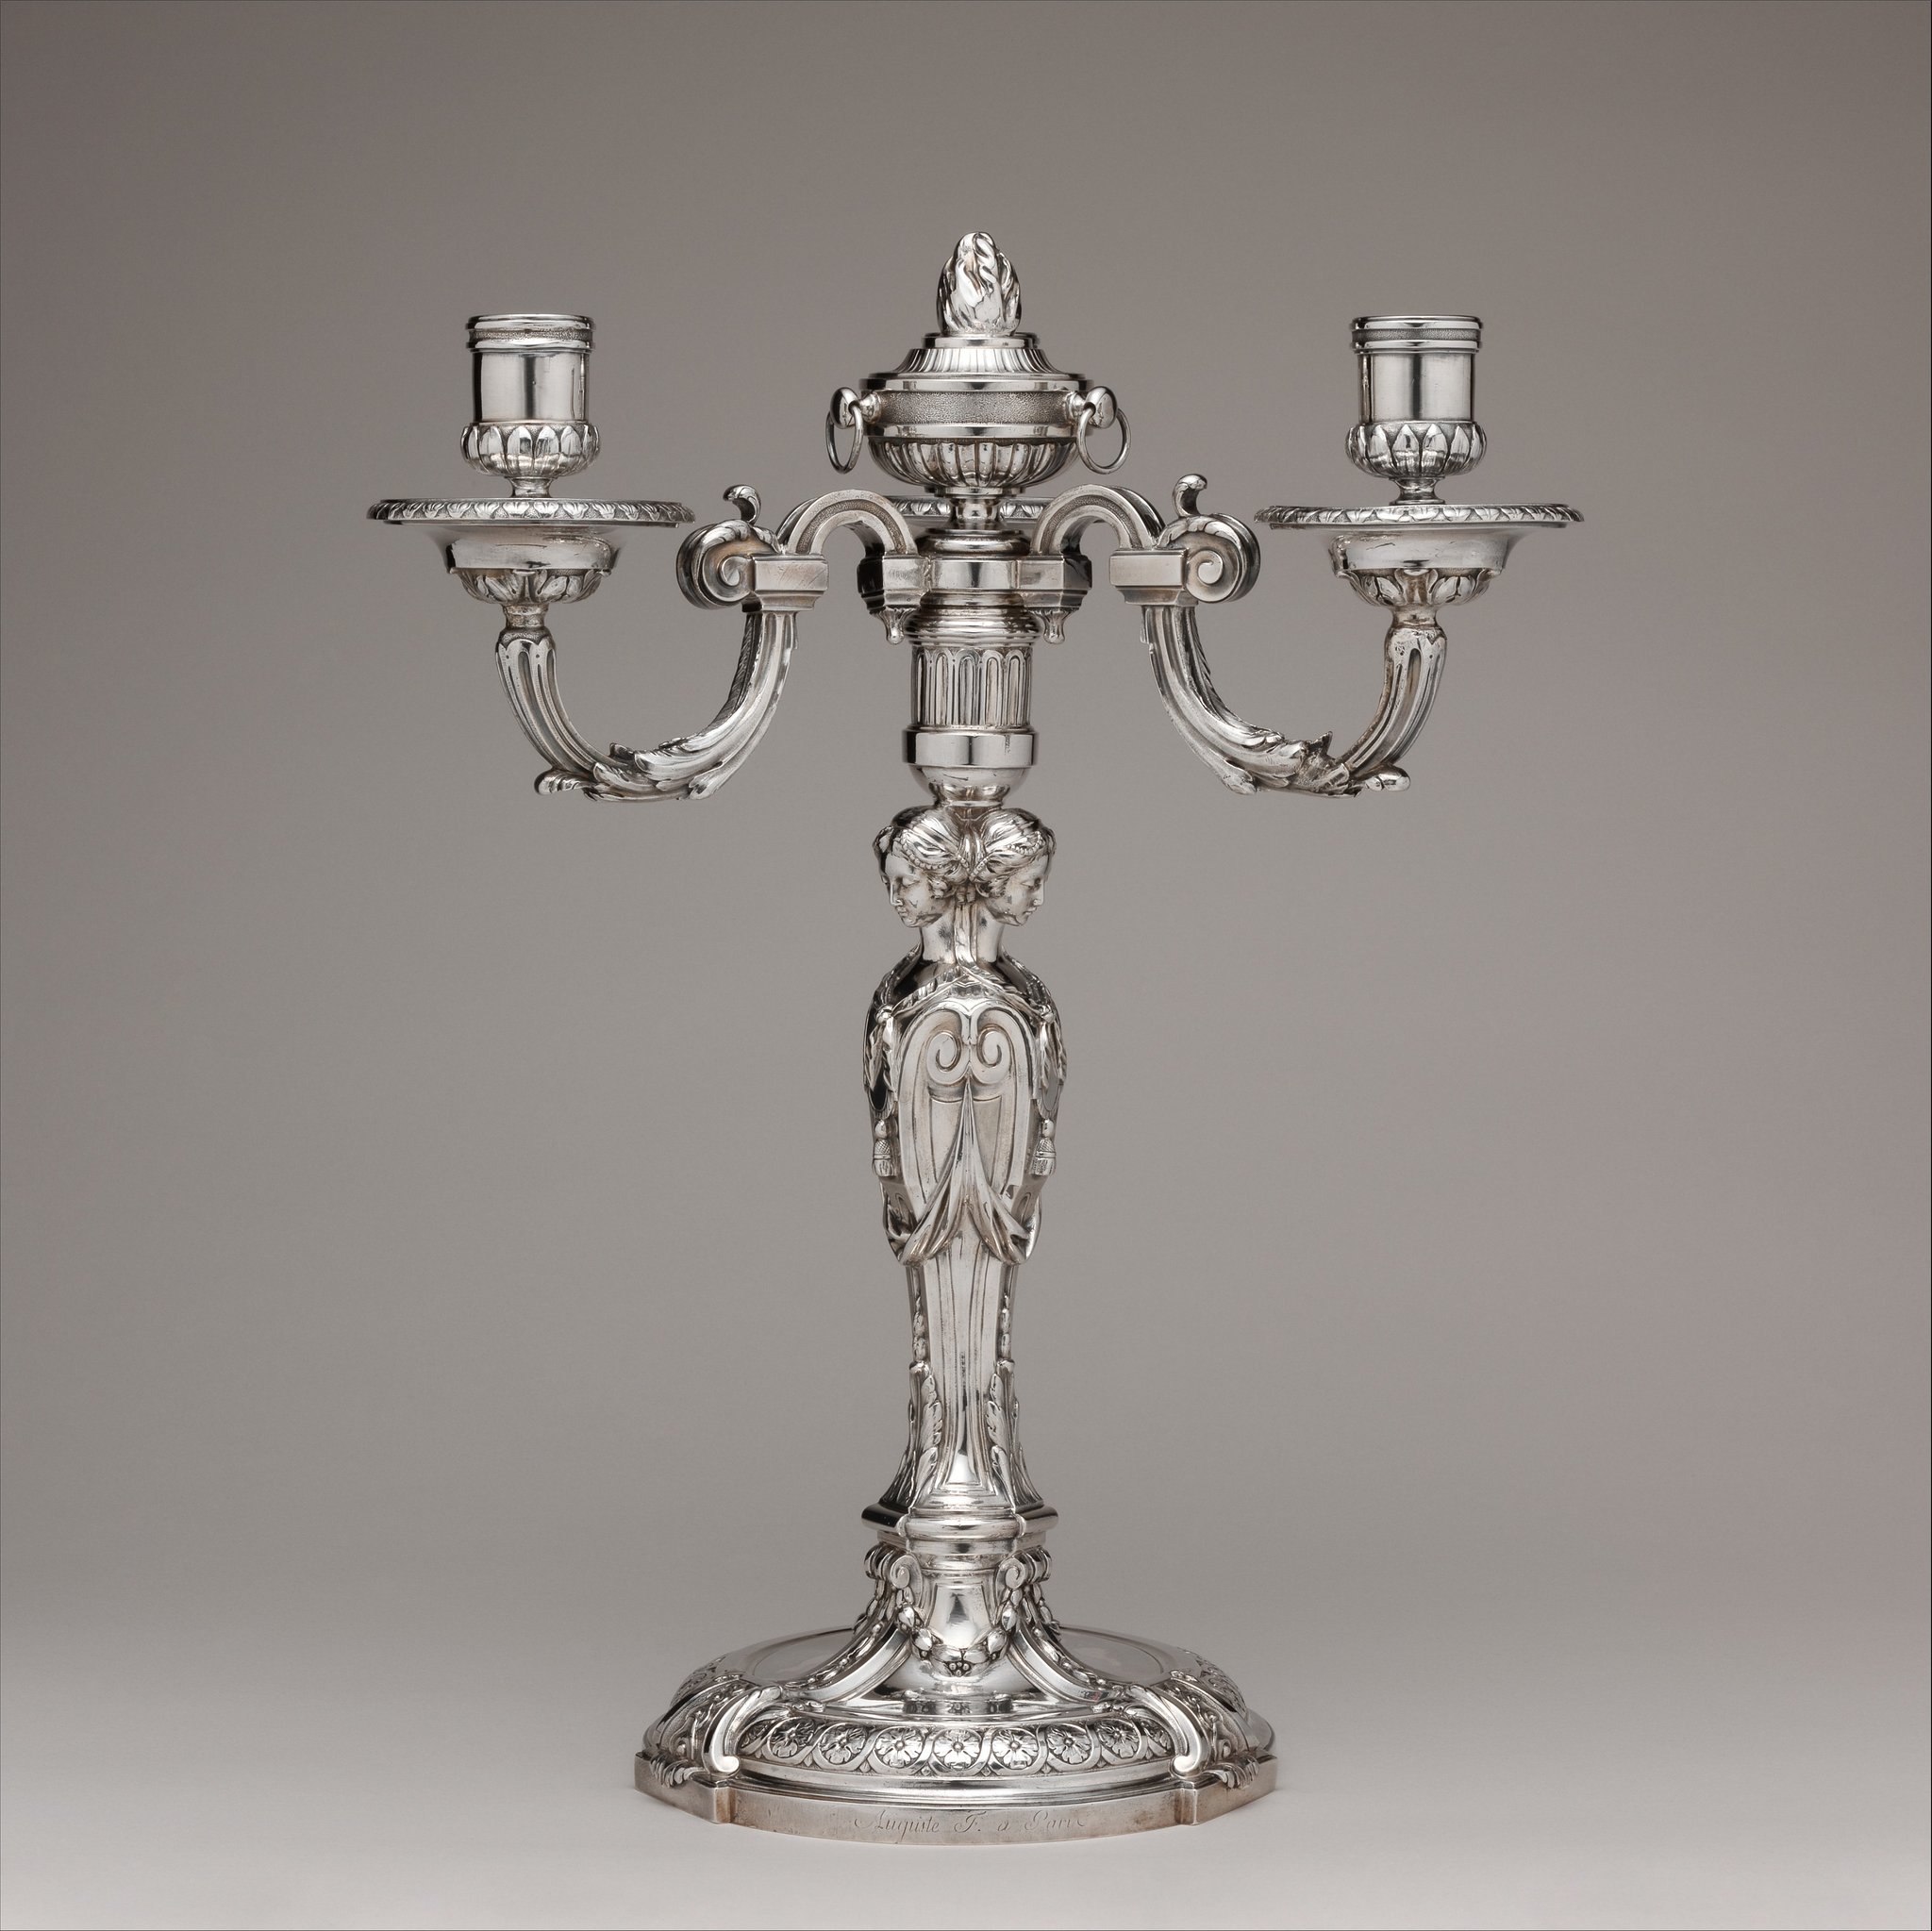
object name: candelabrum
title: Candelabrum (one of a pair)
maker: robert joseph auguste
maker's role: maker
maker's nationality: french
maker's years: 1723-1805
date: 1767-1768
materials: silver